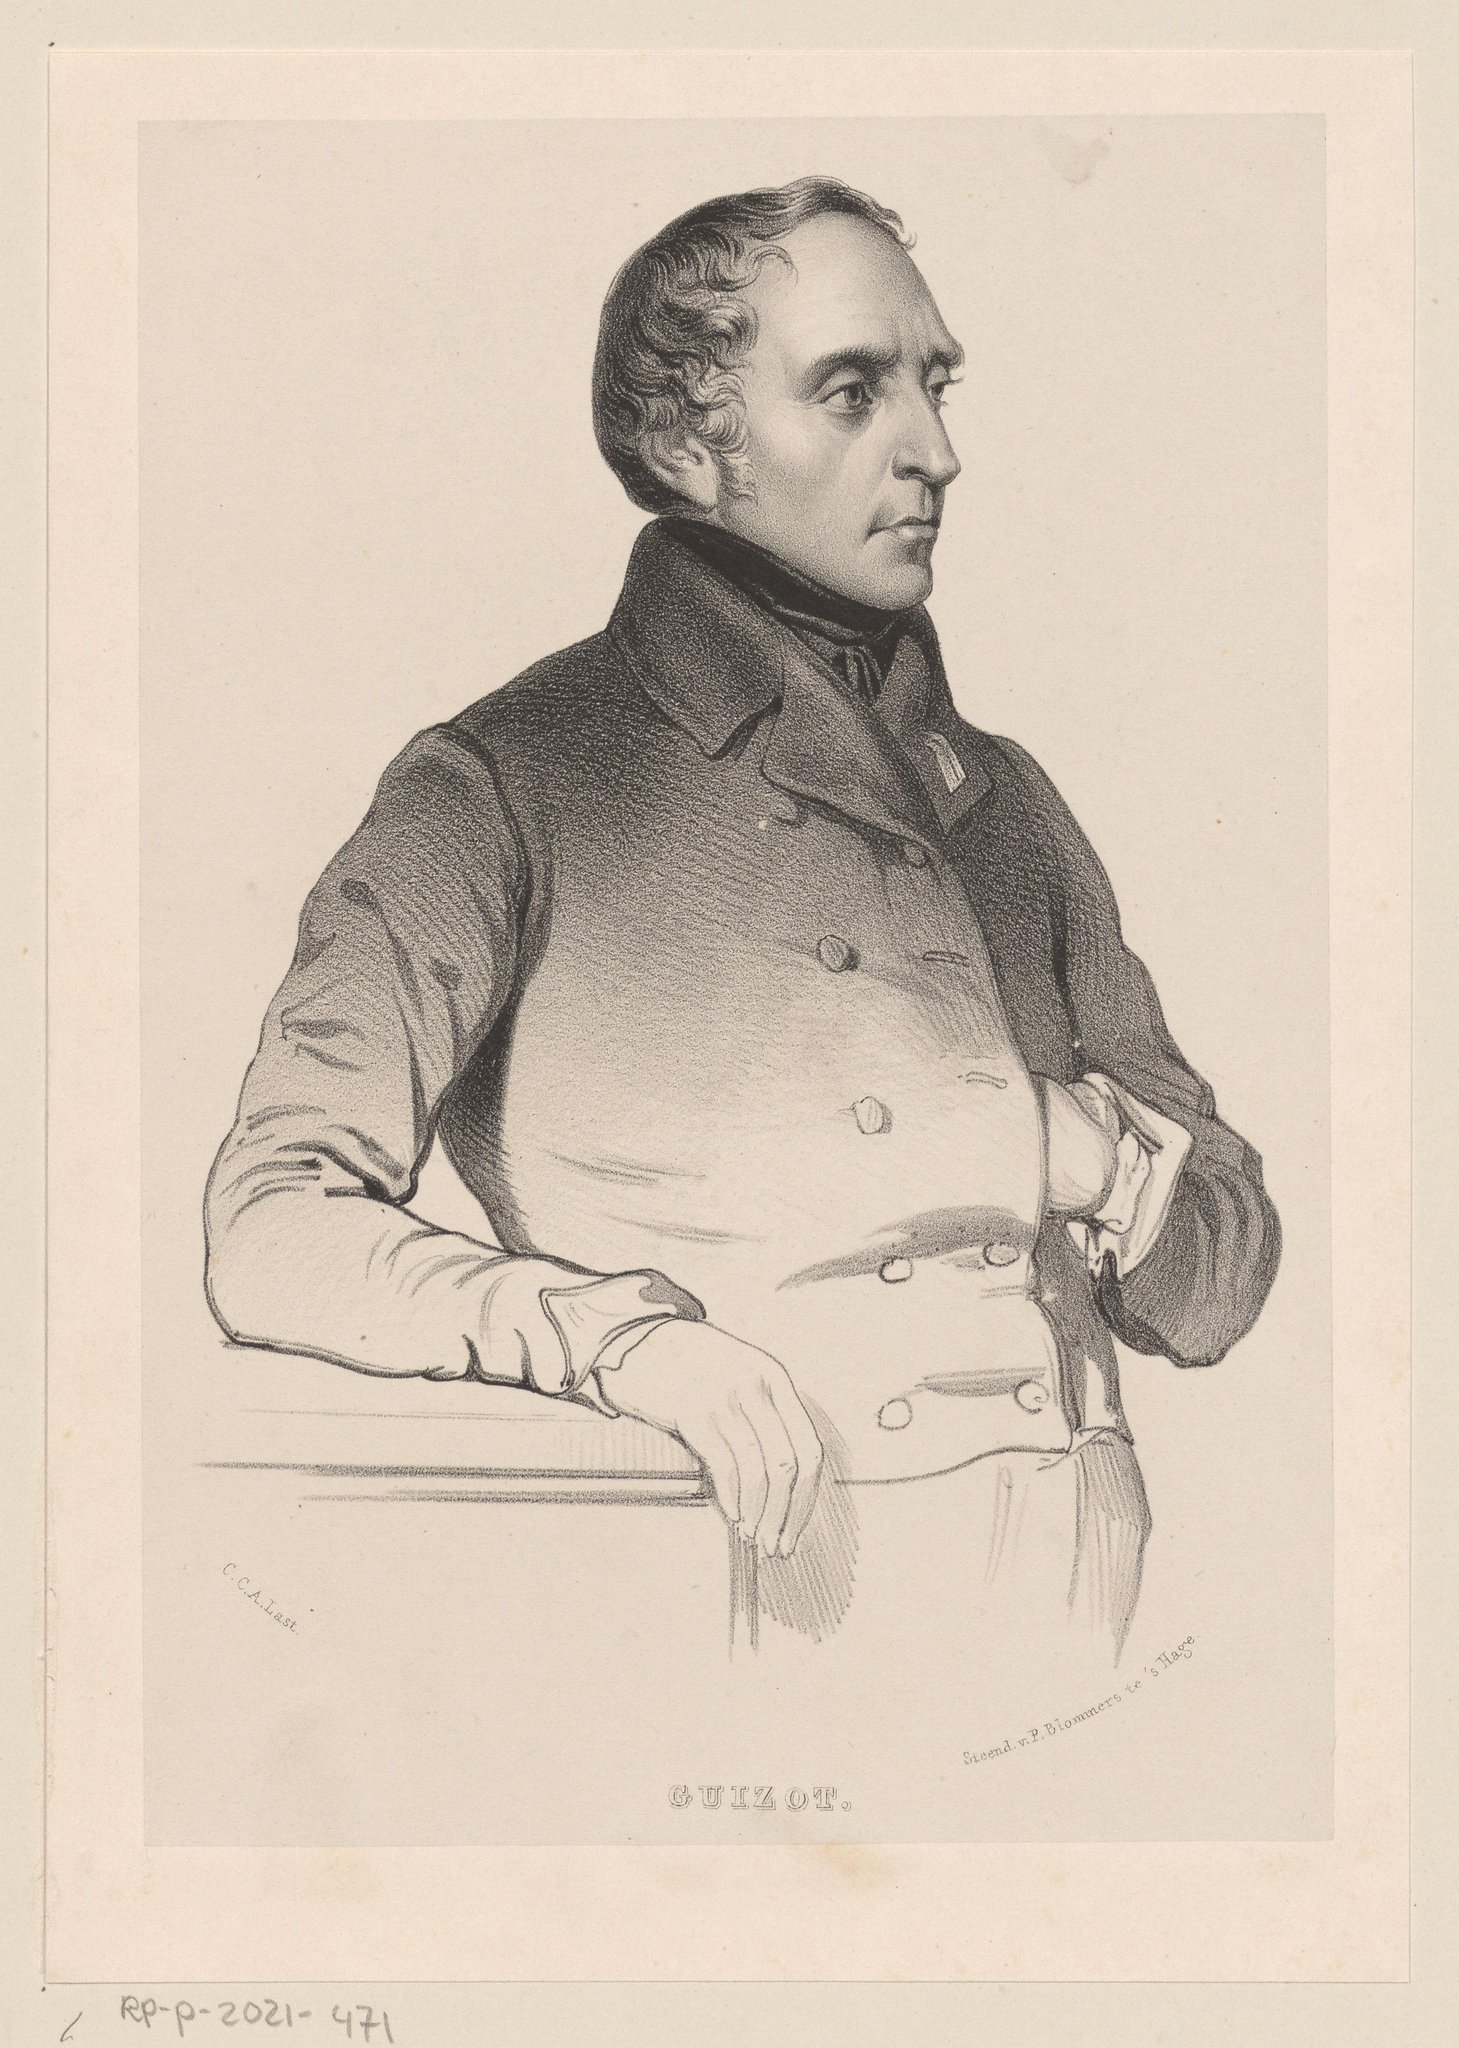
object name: print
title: Portret van François Guizot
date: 1842-1887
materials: paper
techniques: lithograph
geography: the hague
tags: prime minister, history and archaeology (+ portrait of scholar, scientist), historical persons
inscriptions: collector's mark: Lugt 2228